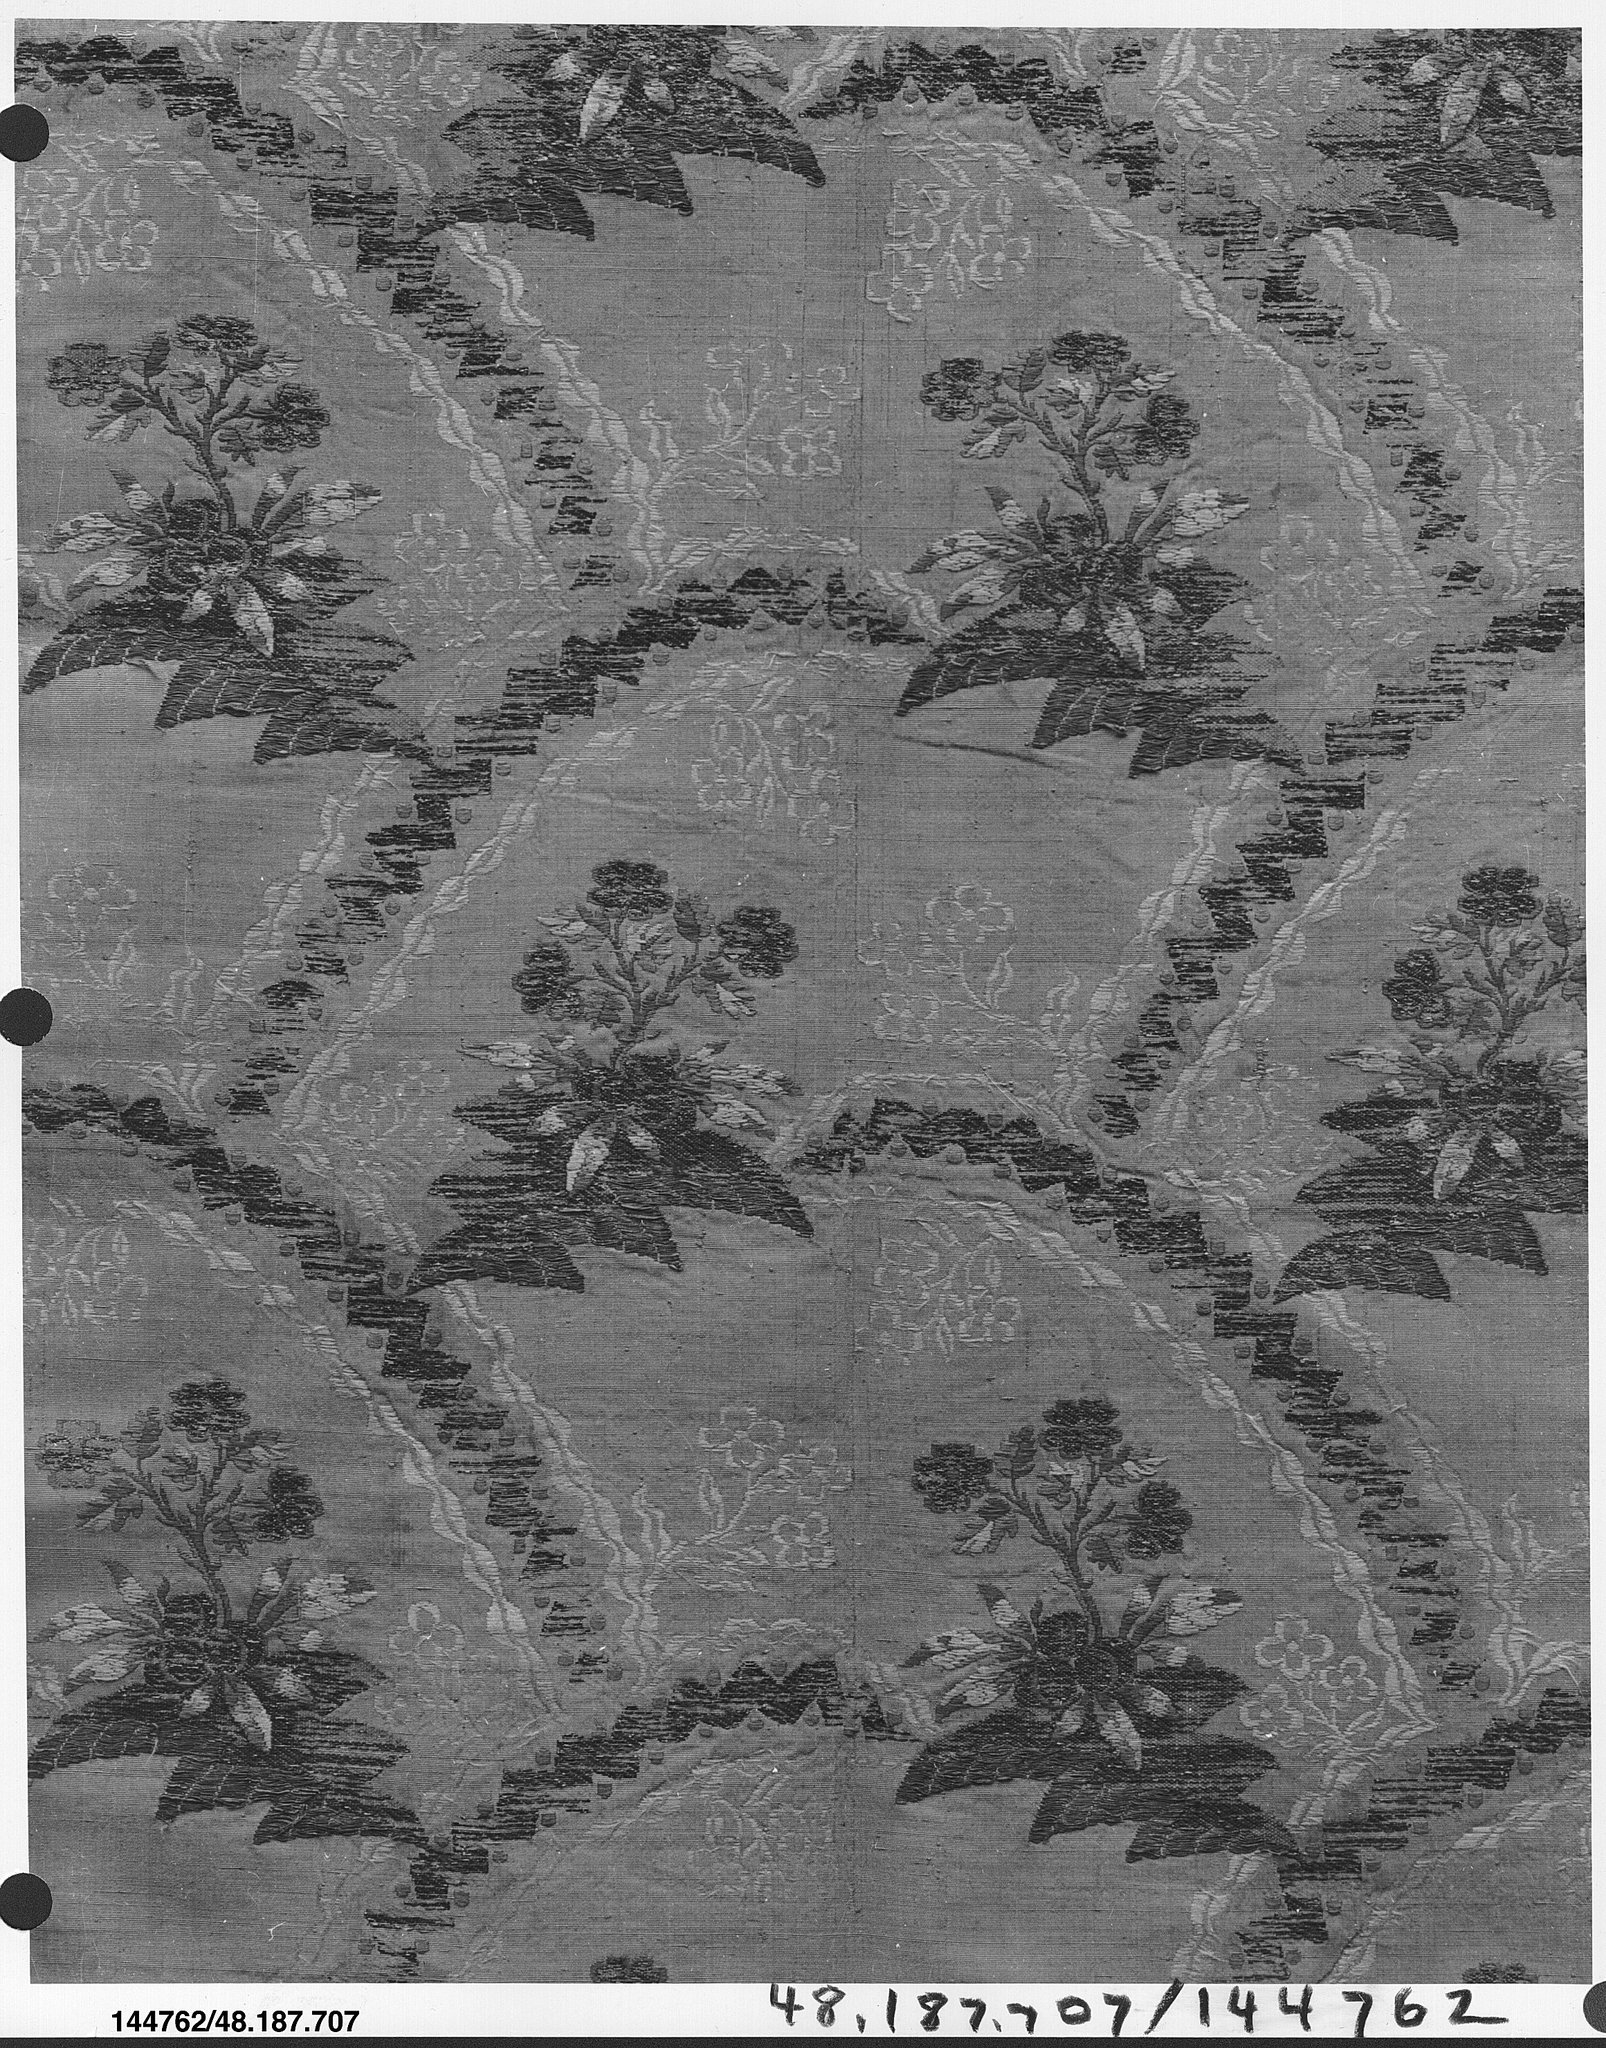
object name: piece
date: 1751-1775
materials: metal thread, silk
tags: flowers,leaves